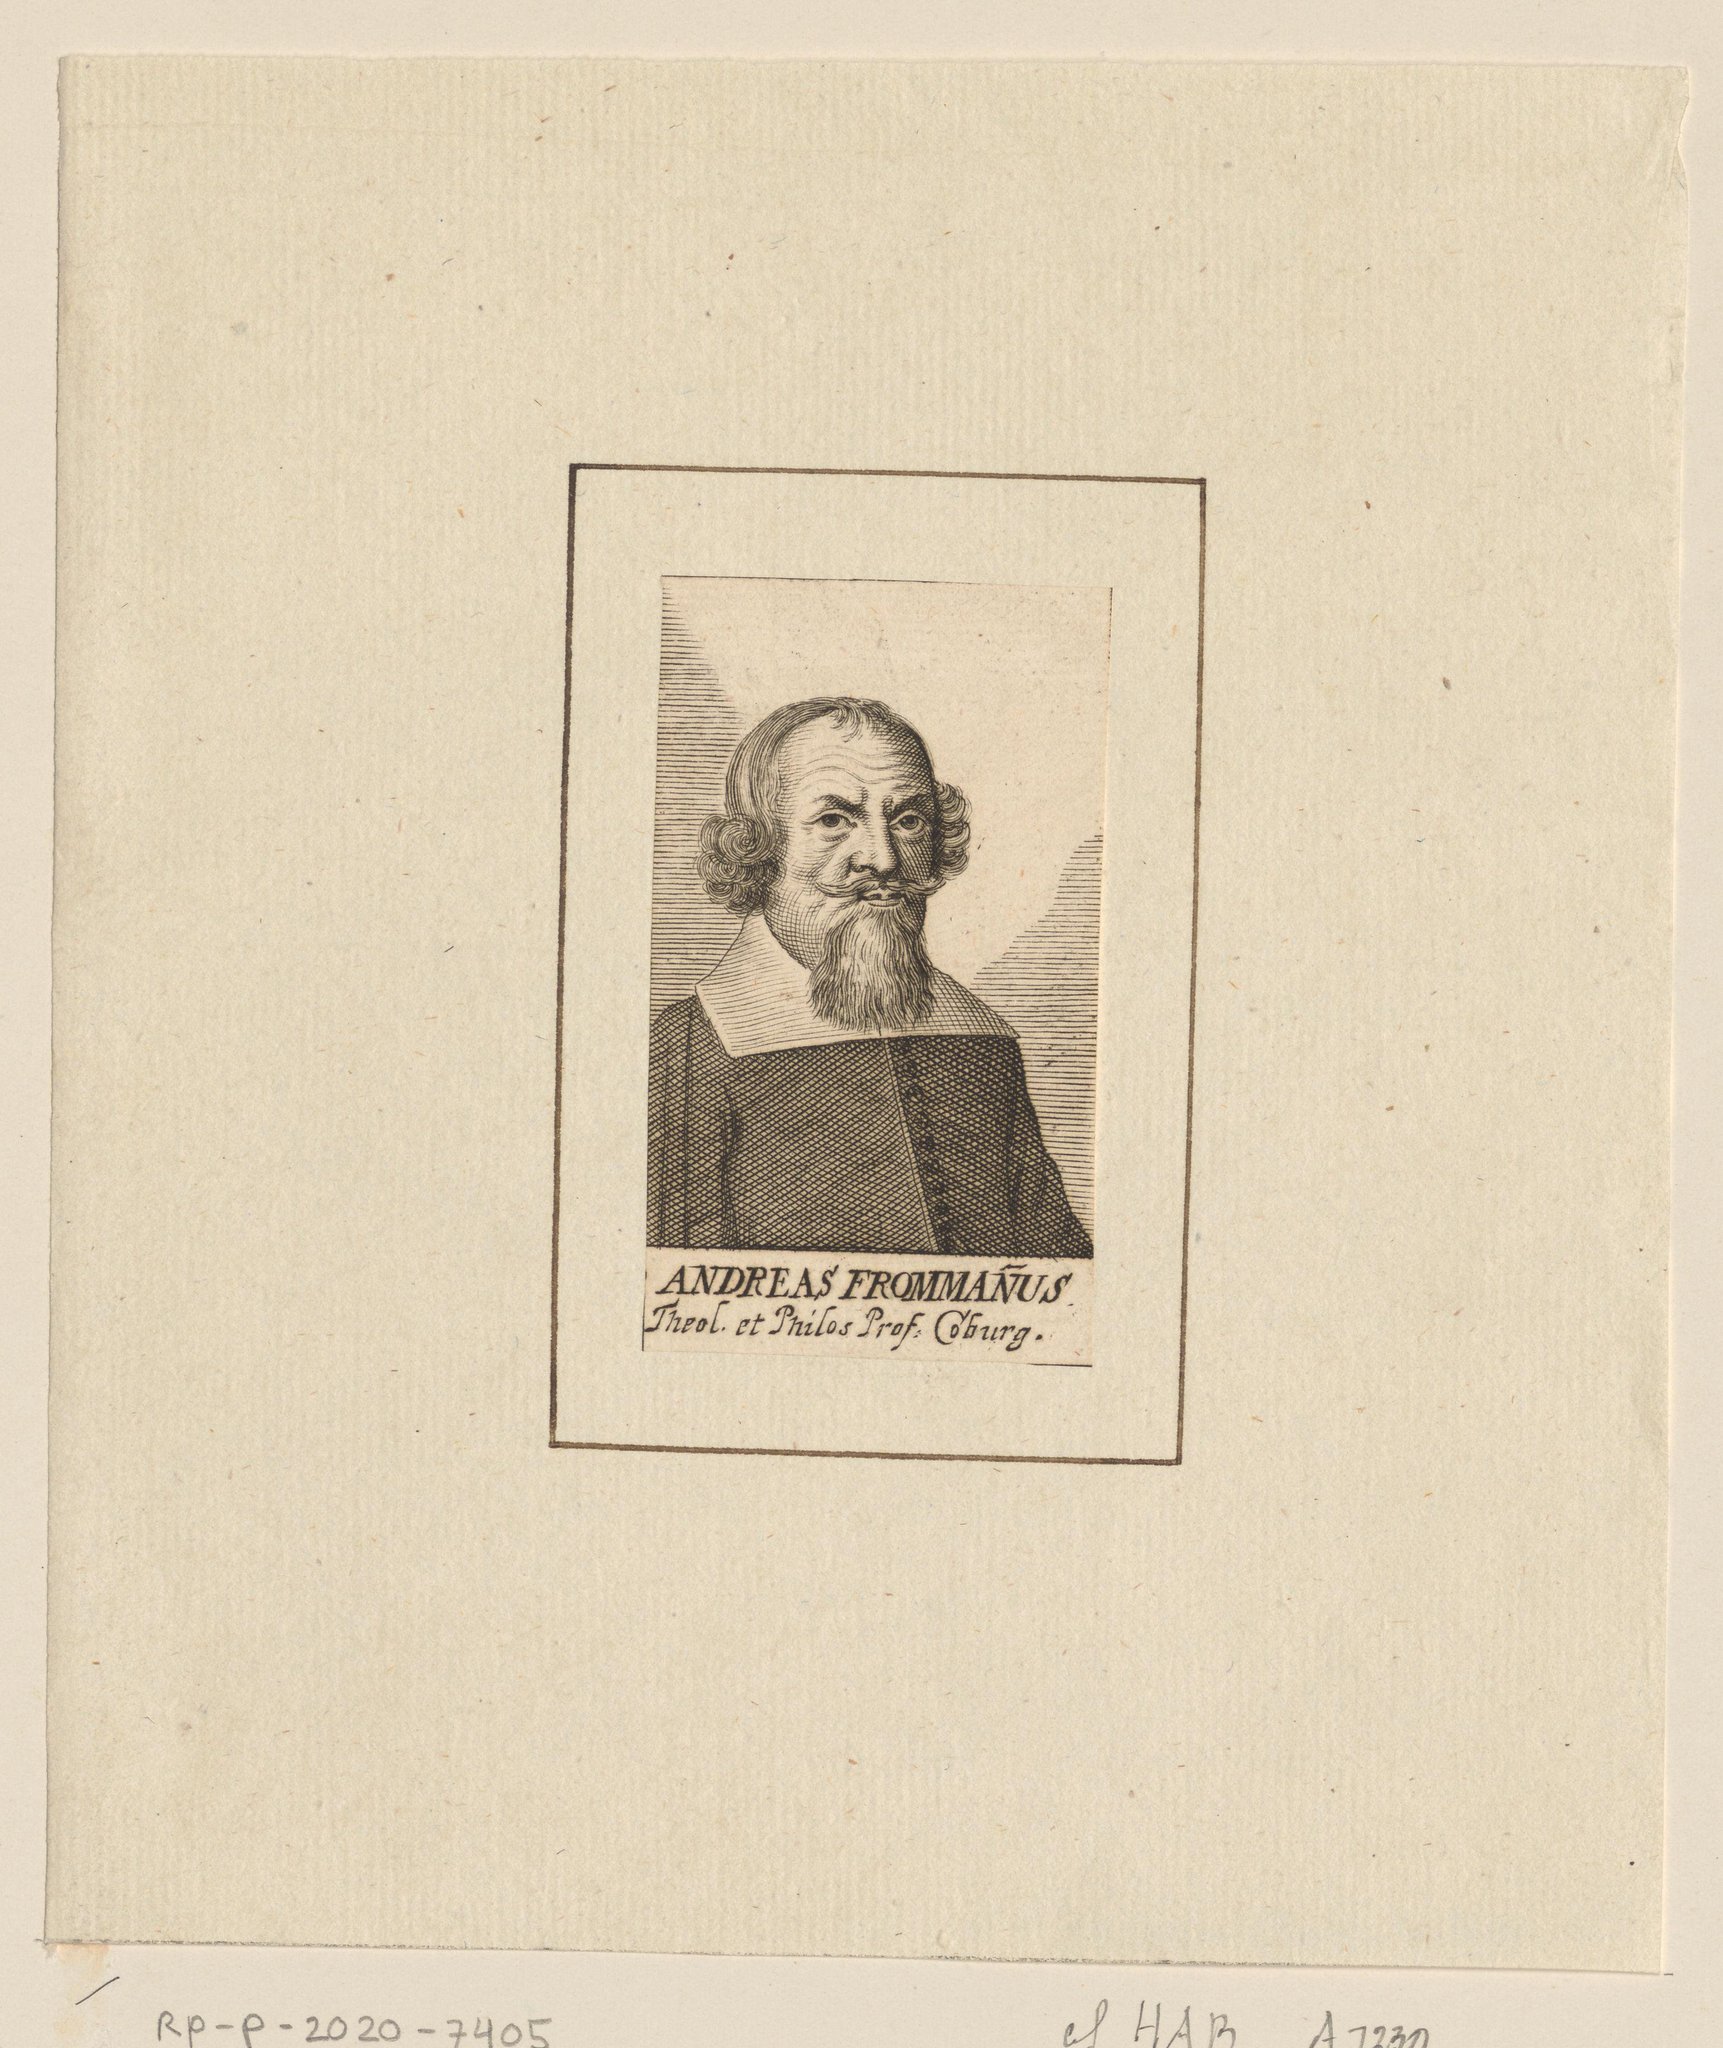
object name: print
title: Portret van Andreas Frommann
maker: Anonymous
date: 1688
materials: paper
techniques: engraving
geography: germany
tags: theologian, historical persons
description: Prent waarschijnlijk uit: Freher, Paul. Theatrum virorum eruditione clarorum. Neurenberg: Johann Hoffmann, 1688.